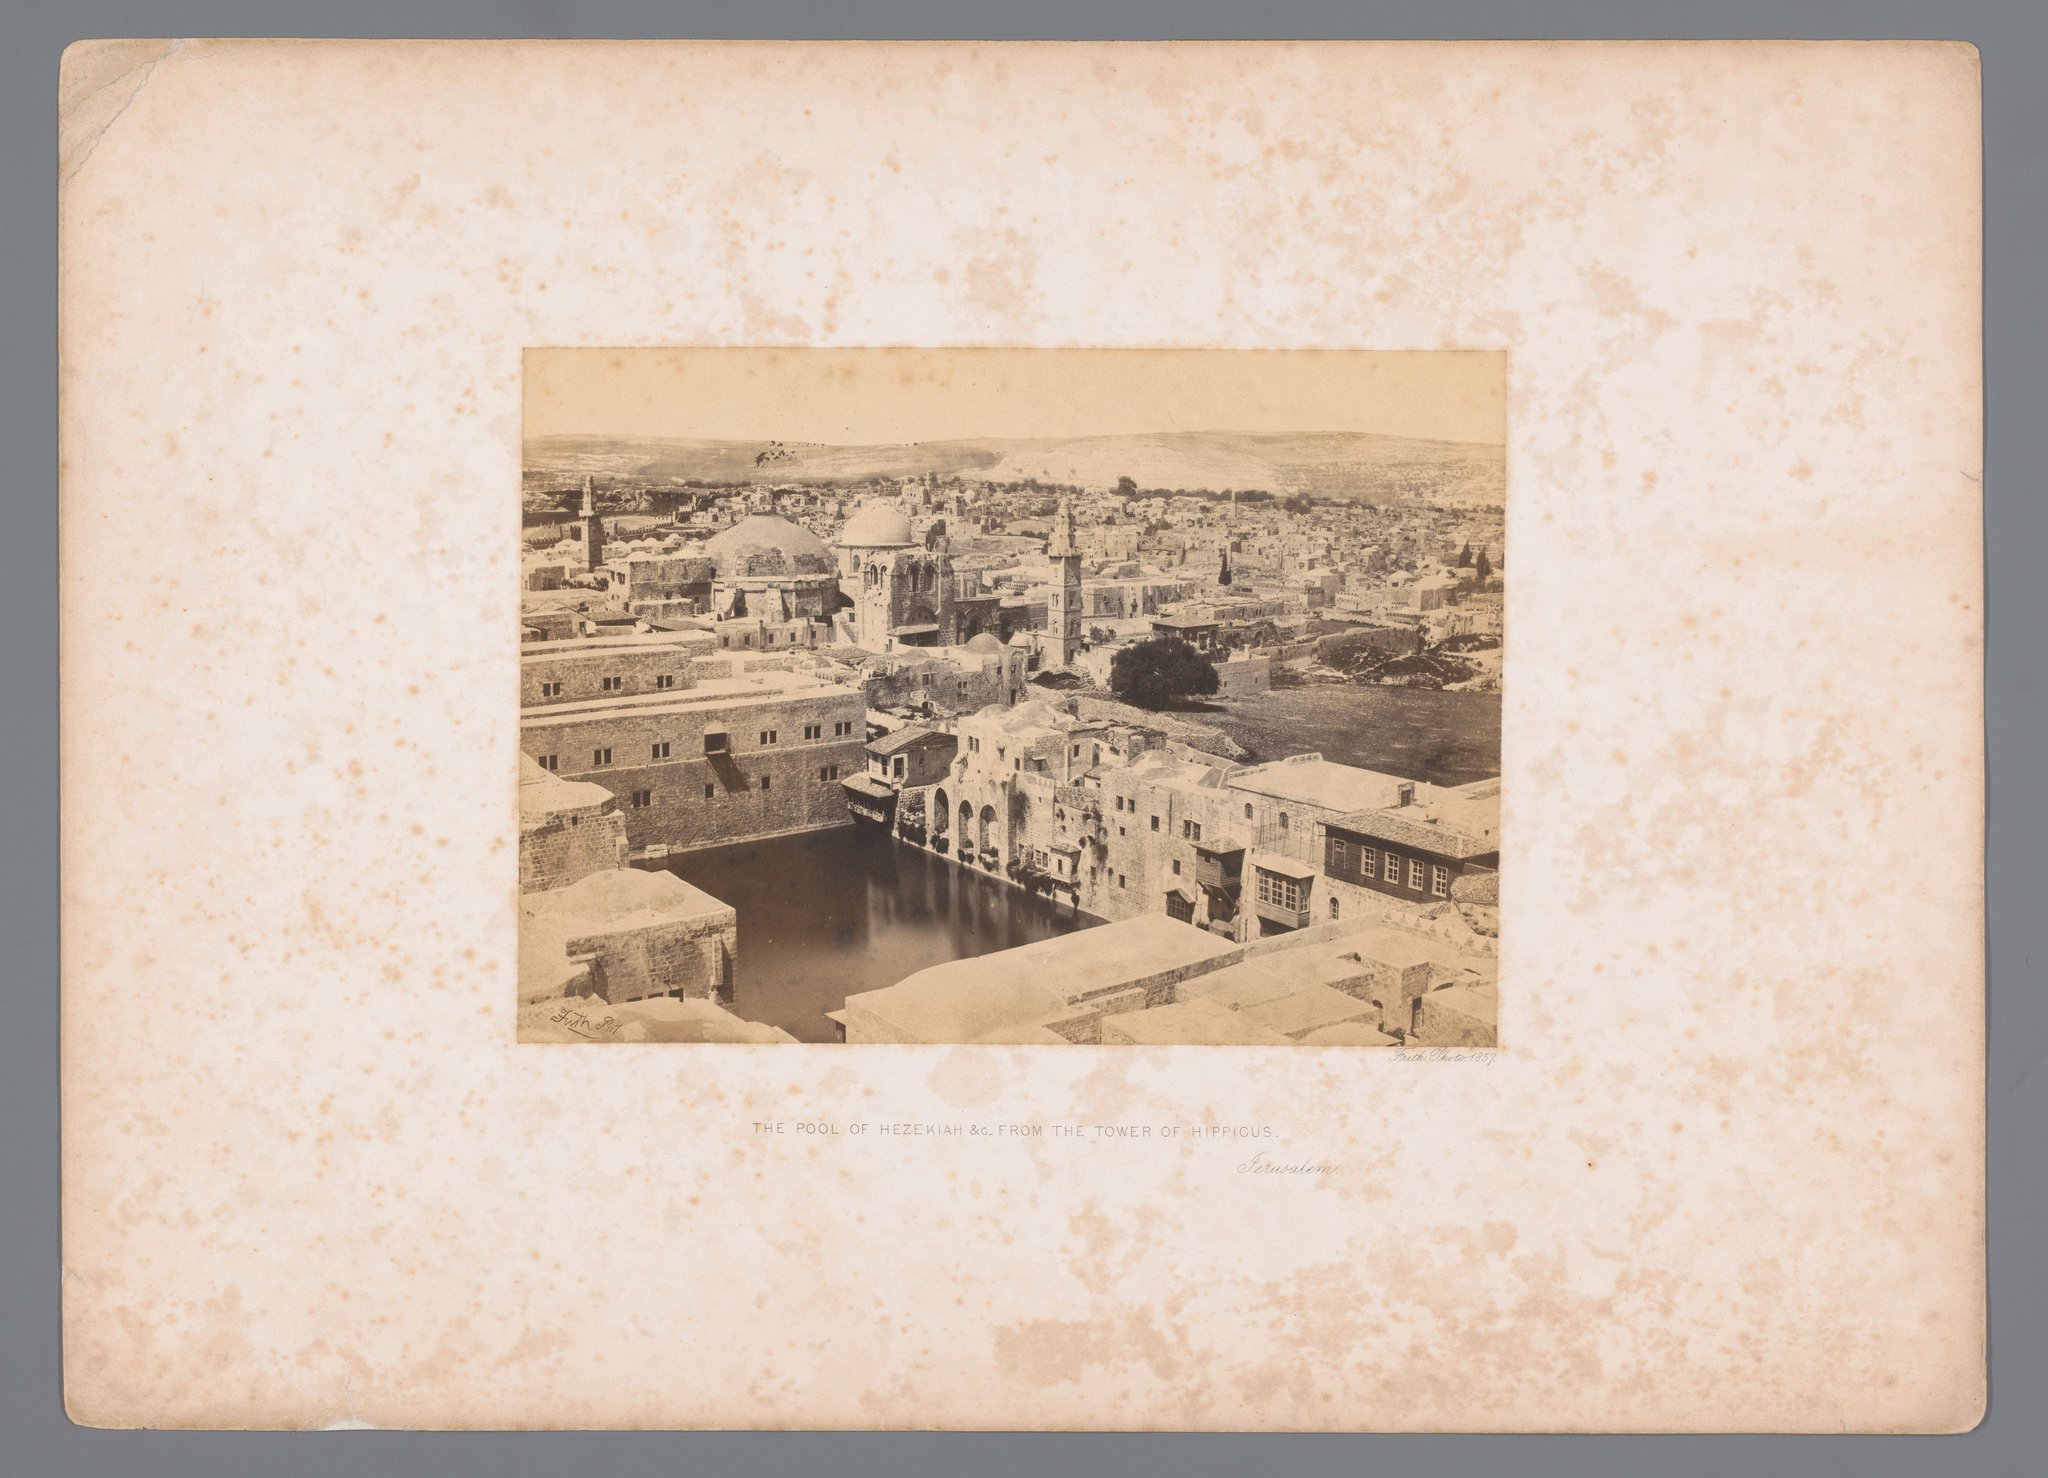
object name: page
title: The pool of Hezekiah &c_ fom the tower of Hippicus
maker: francis frith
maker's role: publisher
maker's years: 1822-1898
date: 1857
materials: paper, photographic support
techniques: albumen print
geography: jerusalem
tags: publisher, francis frith, city-view, and landscape with man-made constructions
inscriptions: inscription: ‘Jerusalem’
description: Deze foto maakt deel uit van een omslag met 7 bladen met albuminedrukken.